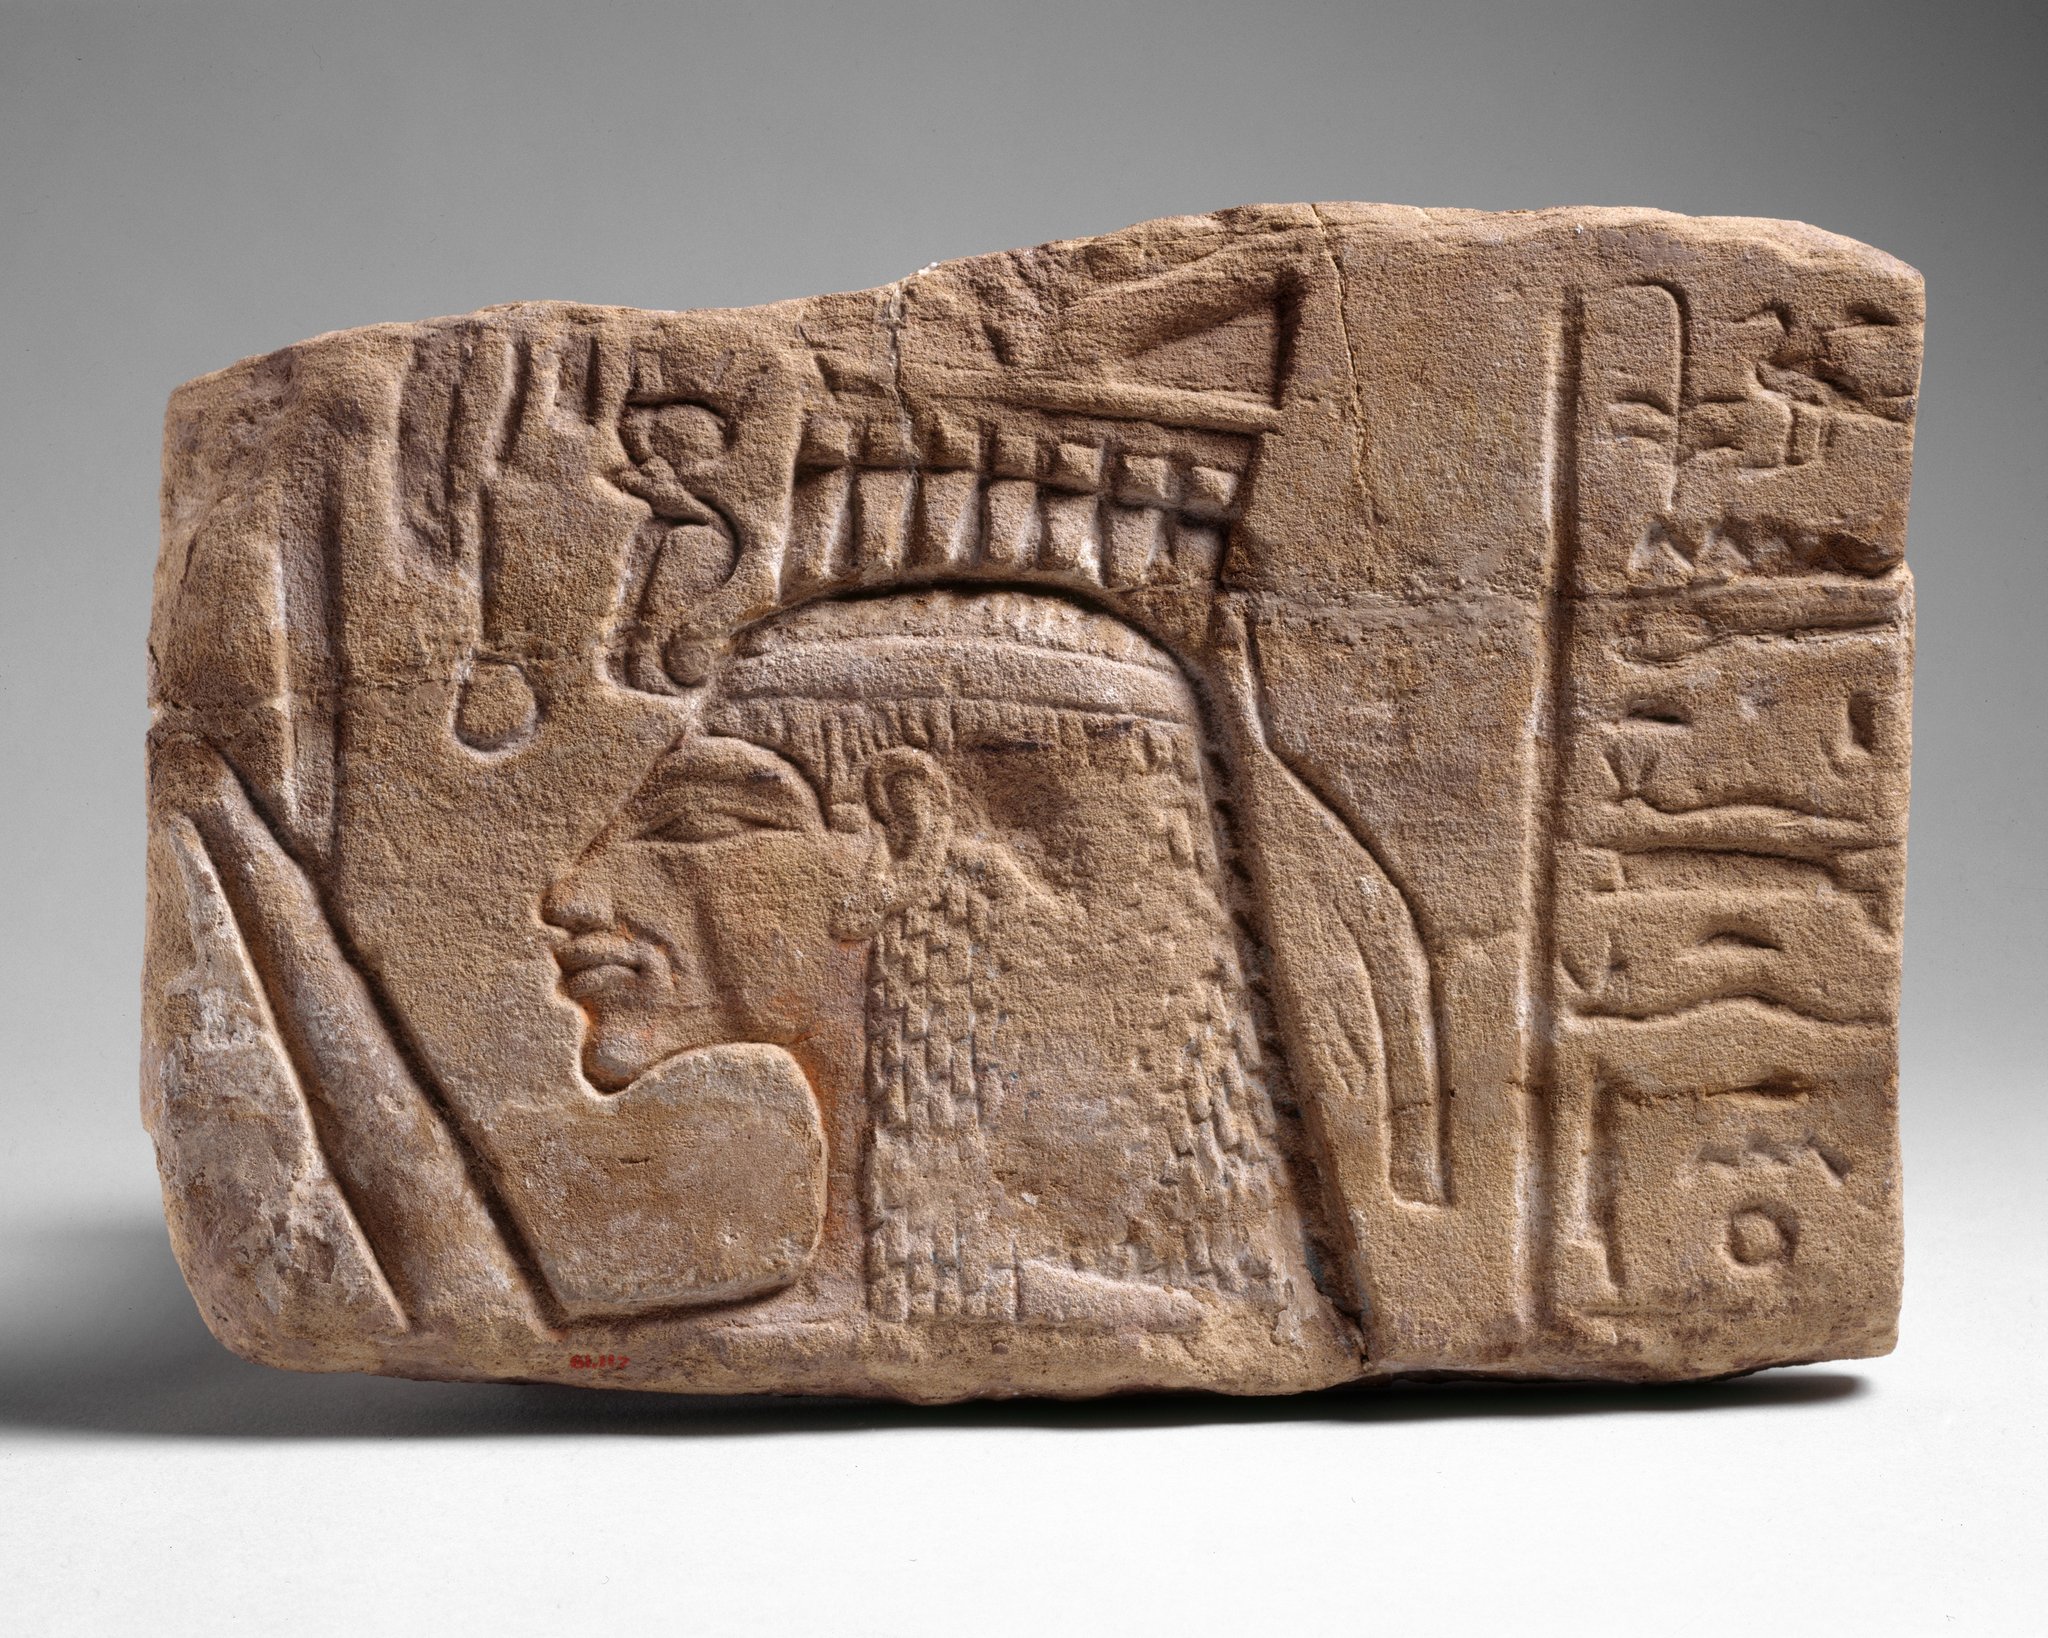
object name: relief, queen nefertiti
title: Relief of Queen Nefertiti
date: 1353-1336 BCE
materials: stone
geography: upper egypt, thebes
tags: nefertiti